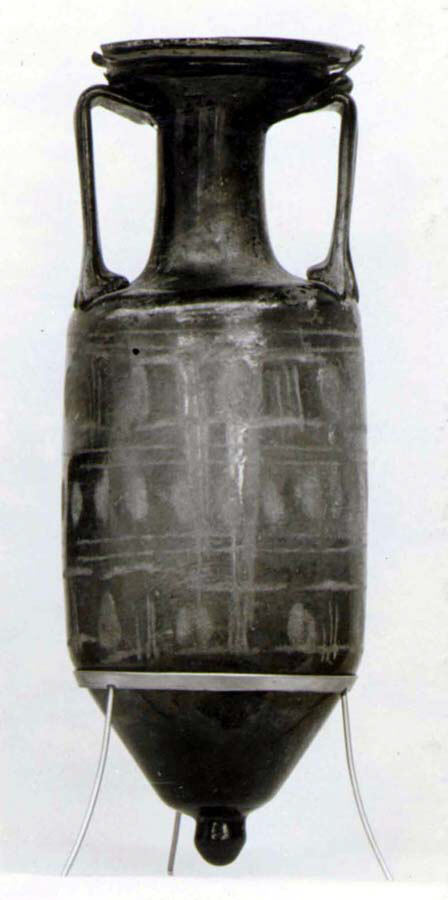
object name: amphora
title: Glass two-handled bottle (amphora)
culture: roman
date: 301-400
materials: glass